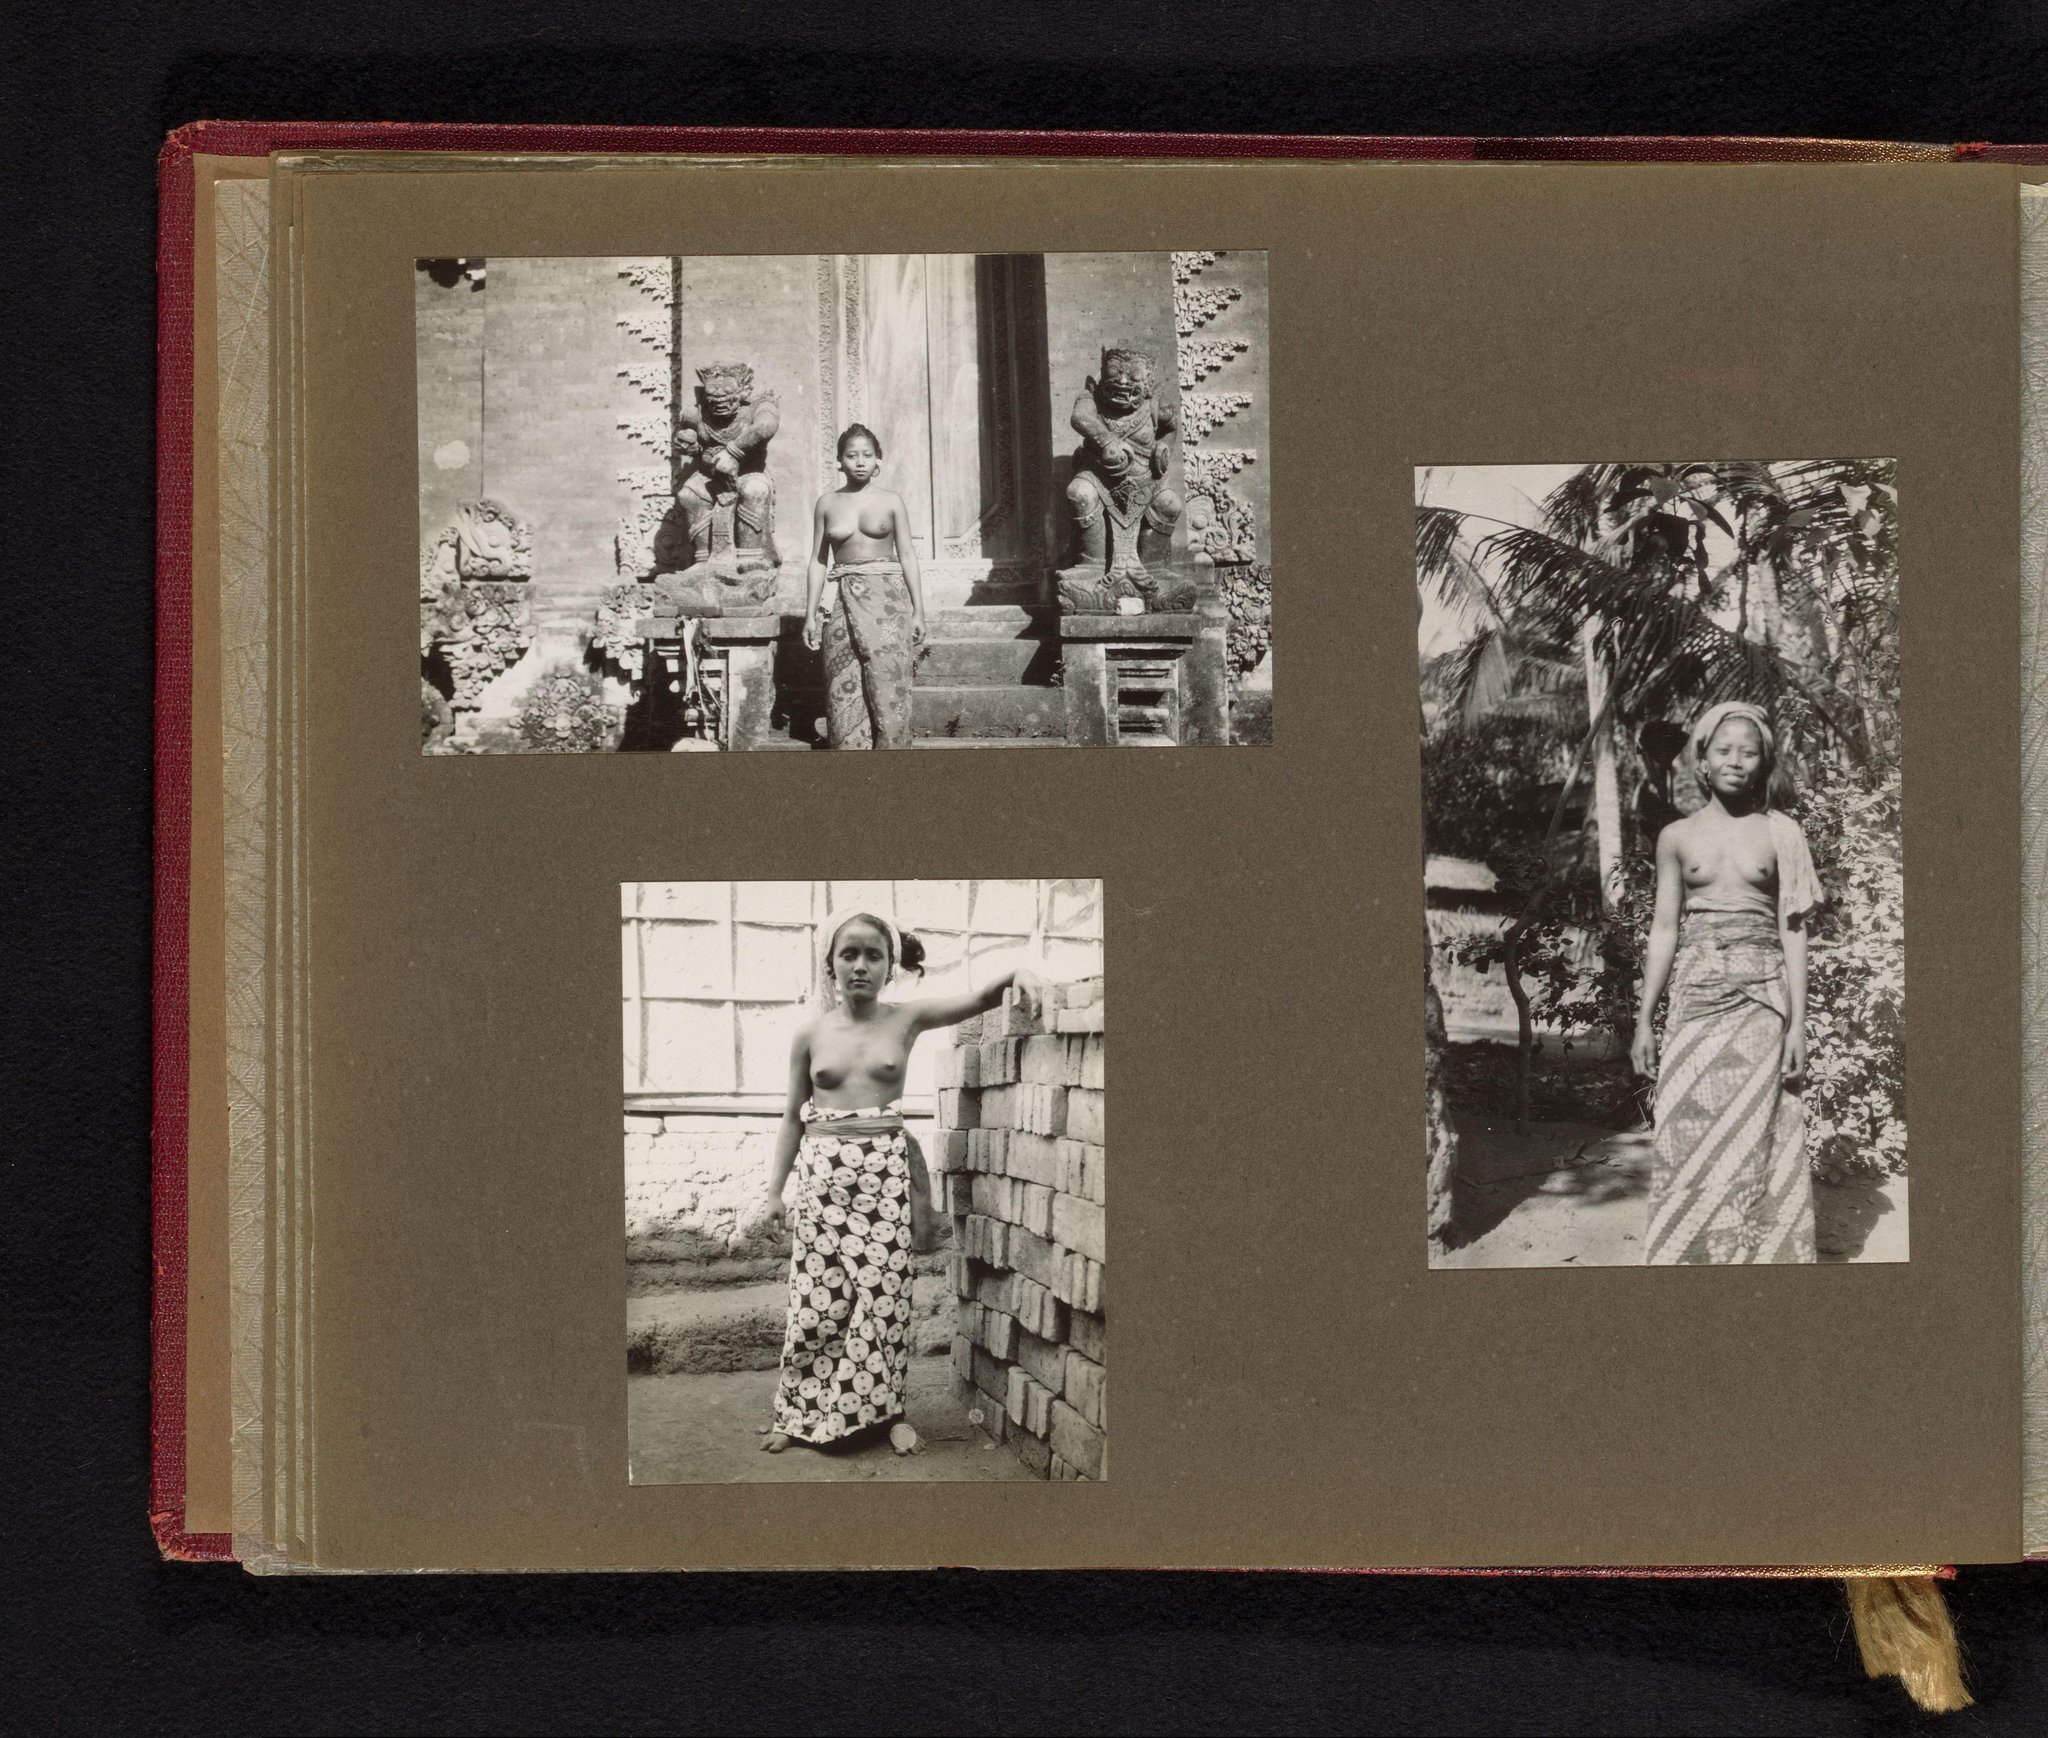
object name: photograph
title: Drie portretten van jonge vrouwen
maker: Anonymous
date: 1950-1960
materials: photographic support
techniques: gelatin silver print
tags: adolescent, young woman, maiden, dutch east indies, the